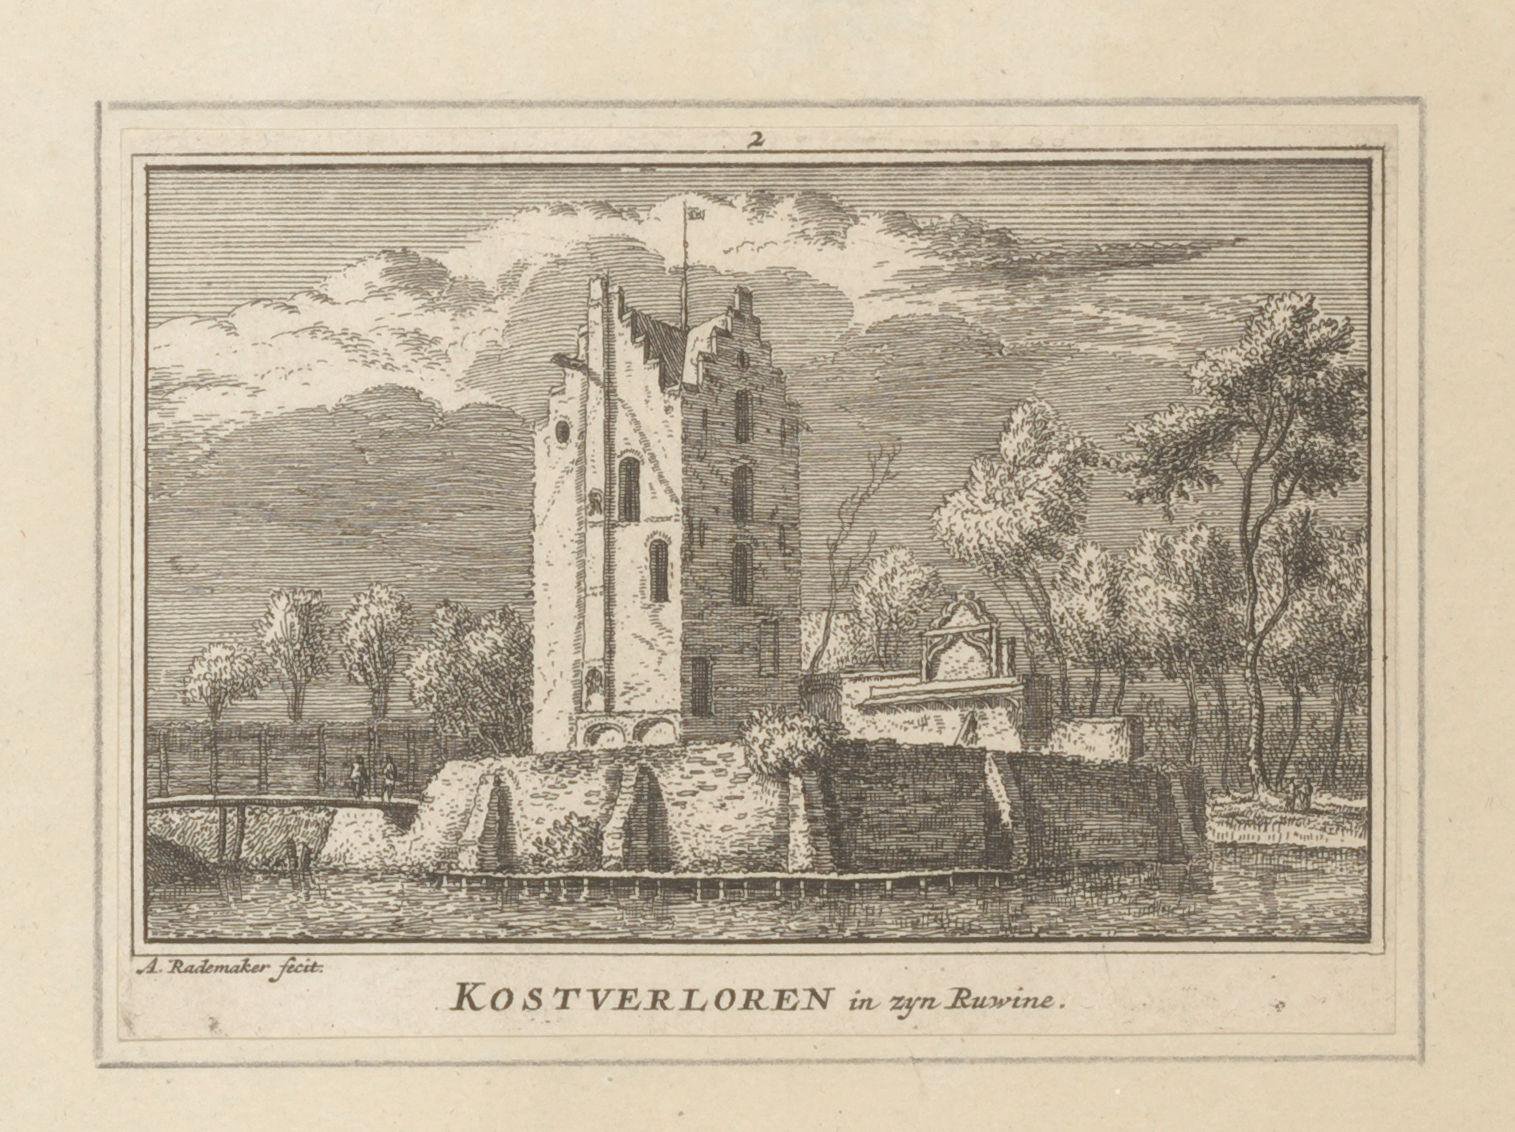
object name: print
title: Gezicht op Huis Kostverloren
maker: abraham rademaker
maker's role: draughtsman, print maker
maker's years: 1676-1735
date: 1725-1803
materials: paper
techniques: etching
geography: amsterdam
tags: city-view in general; 'veduta', river, rural housing, e.g. country-house, villa, cottage, road, path, bridge, ruin of a dwelling, house, castle, etc.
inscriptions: collector's mark: ‘5’ Lugt 1641b, inscription: ‘de poort / is gebouwd / tusschen 1610 en / 1630’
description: Prent mogelijk uit: Rademaker, Abraham. Kabinet van Nederlandsche outheden en gezichten: vervat in 300 konstplaaten (…). 2 delen. Amsterdam: Willem Barents, 1725, dl. 1, ill. 1. Na 1725 is deze prent nog in verschillende heruitgaven verschenen, uitgegeven in 1727-1733, 1770-1771 en 1792-1803. Uit welke uitgave het huidige exemplaar precies komt is niet na te gaan.